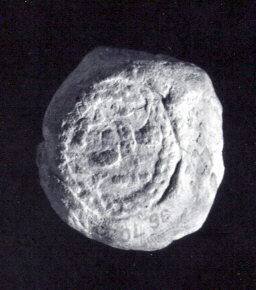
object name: sealing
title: Sealing with four circular impressions of one seal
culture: assyrian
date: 1800-1701 BCE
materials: clay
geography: anatolia